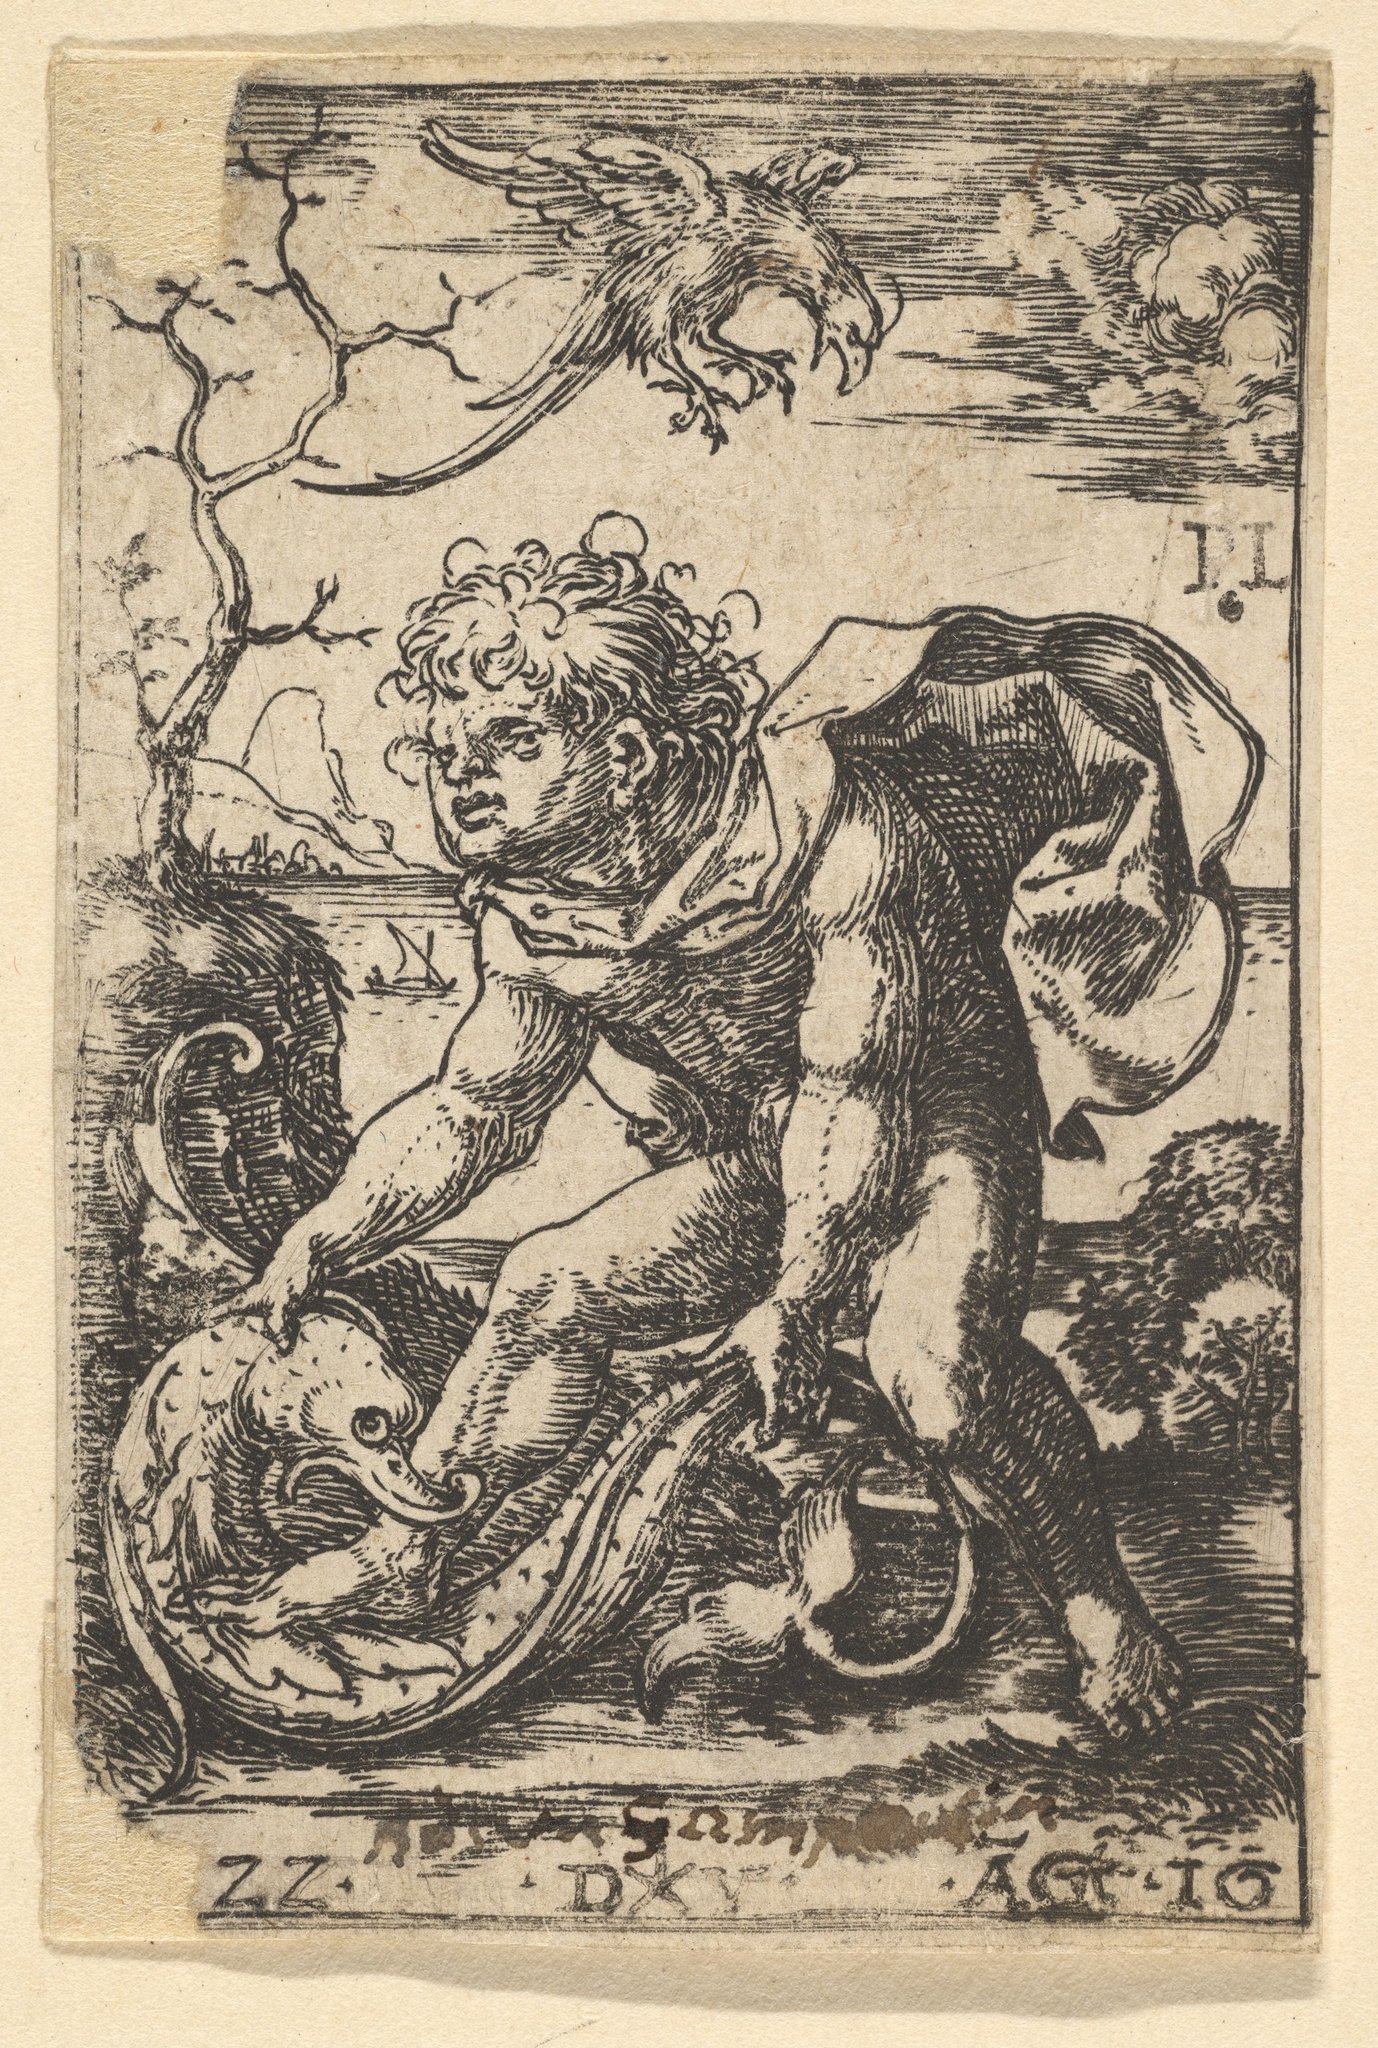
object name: print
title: Man with a Fish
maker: dirck vellert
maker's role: artist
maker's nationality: netherlandish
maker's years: 1475-1552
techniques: engraving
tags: birds,men,fish